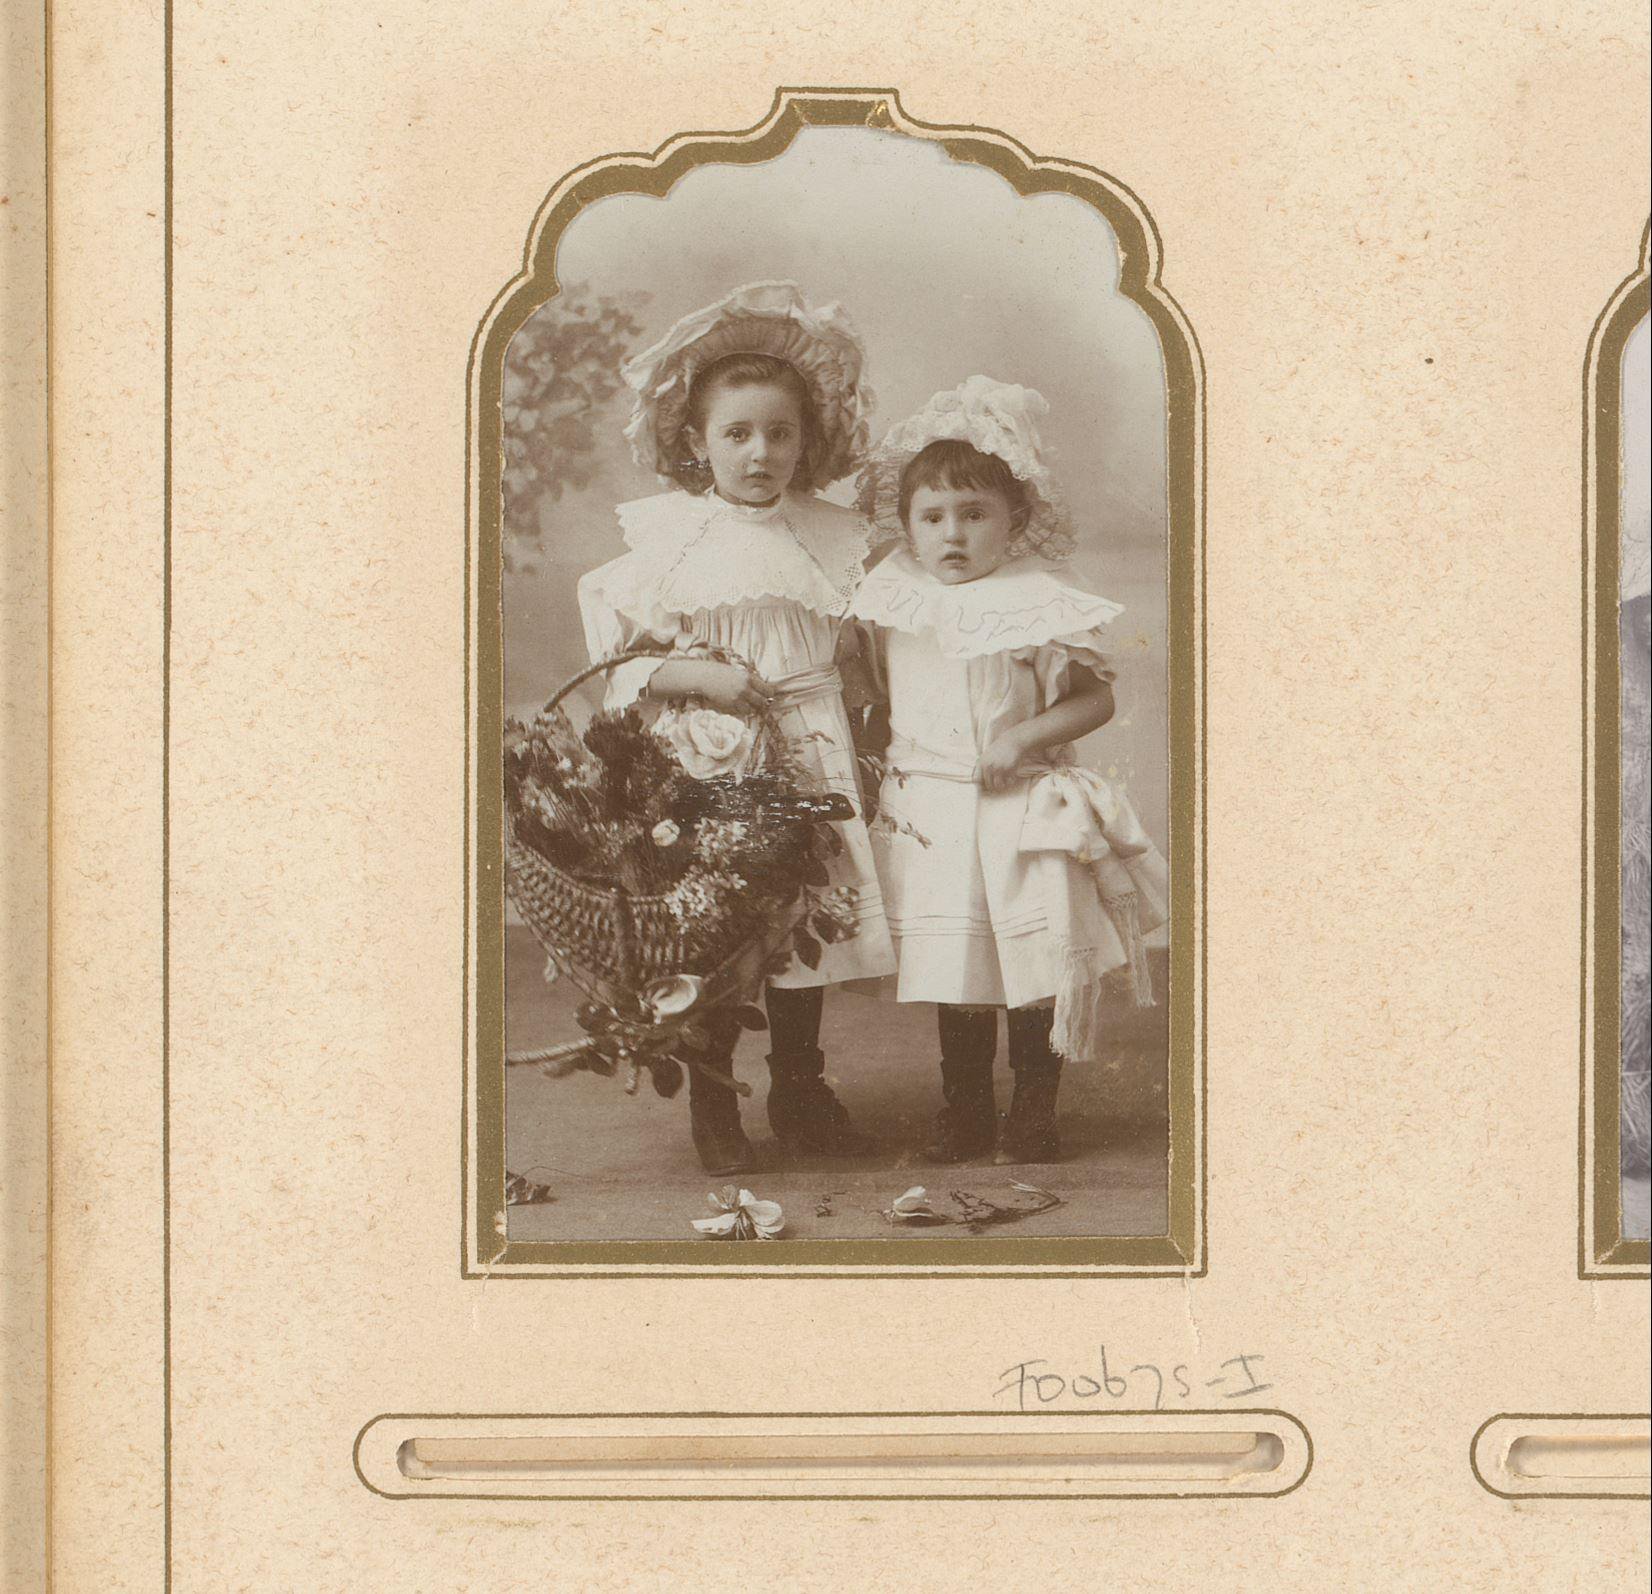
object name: album leaf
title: Portret van twee meisjes in witte jurken en hoeden met mand vol bloemen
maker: joan zwaan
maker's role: draughtsman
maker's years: 1856-1937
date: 1880-1910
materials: cardboard, photographic support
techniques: collodion silver print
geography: the hague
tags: girl (child between toddler and youth)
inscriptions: inscription: ‘J. van Zwaam/ Asserdelftstraat 34/ Den Haag’